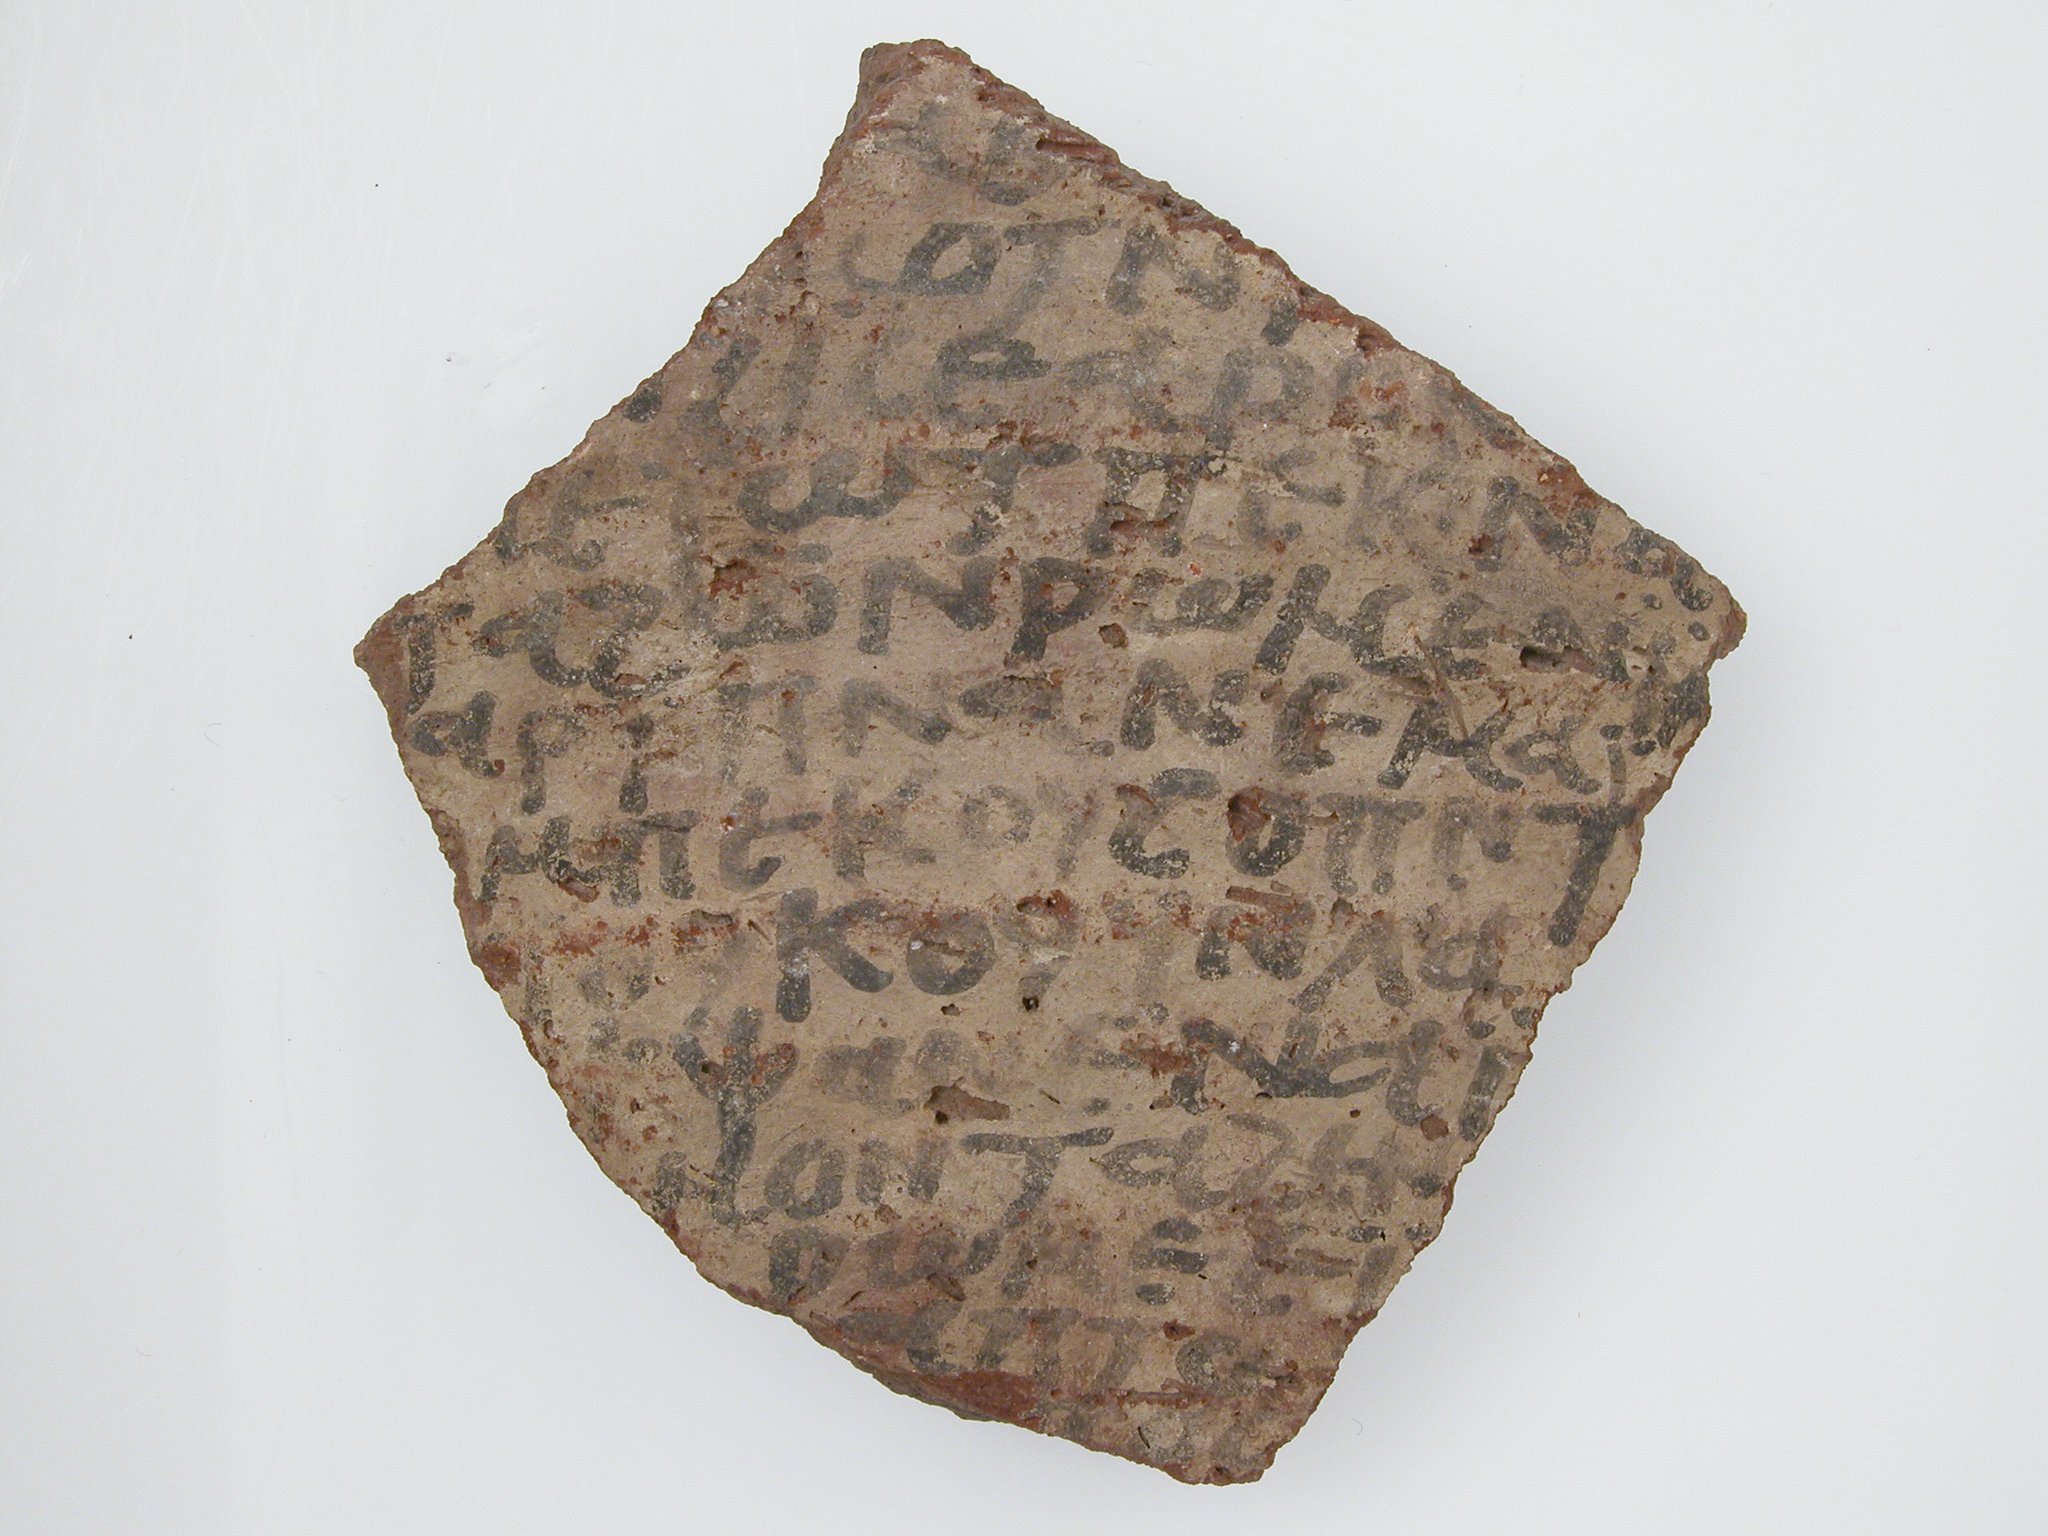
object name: ostrakon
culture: coptic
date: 601-700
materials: ink, pottery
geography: egypt